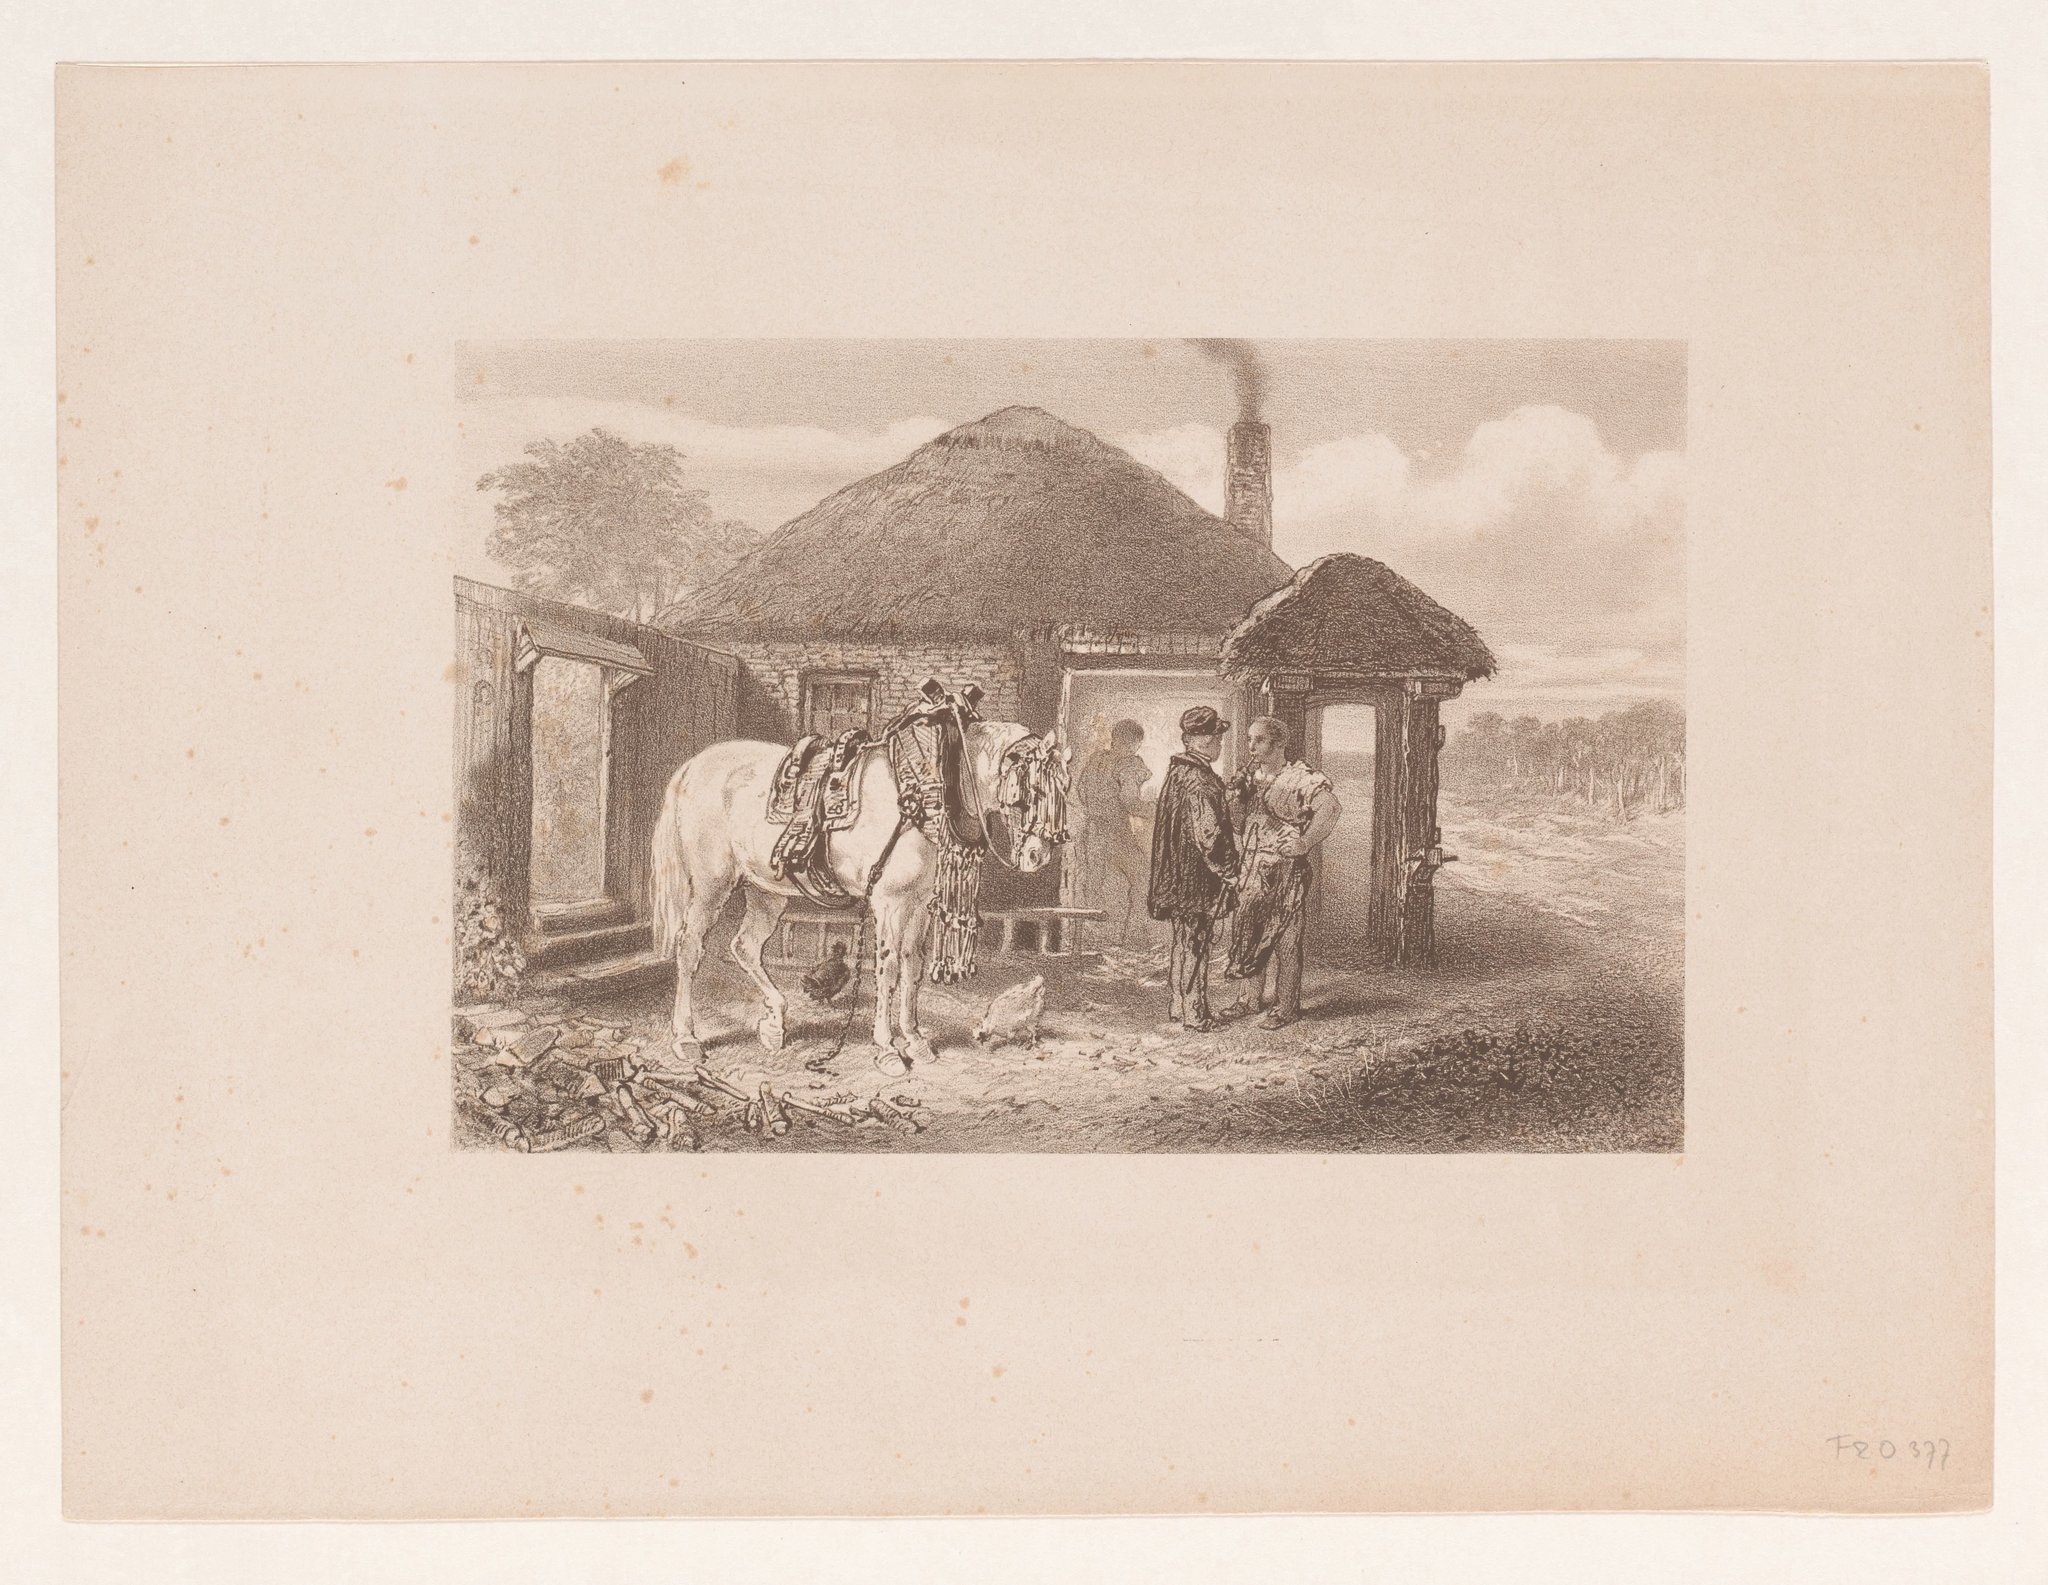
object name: print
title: Hoefsmid in gesprek met man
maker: charles rochussen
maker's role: draughtsman, painter, print maker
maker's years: 1814-1894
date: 1824-1894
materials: paper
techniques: lithograph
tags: farrier, shoeing-smith, horse, conversation, dialogue; conversation piece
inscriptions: collector's mark: Lugt 2228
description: Een hoefsmid in gesprek met een (voer)man met zweep. Links staat een opgetuigd paard. In de achtergrond is een hoefsmid aan het werk in de werkplaats.